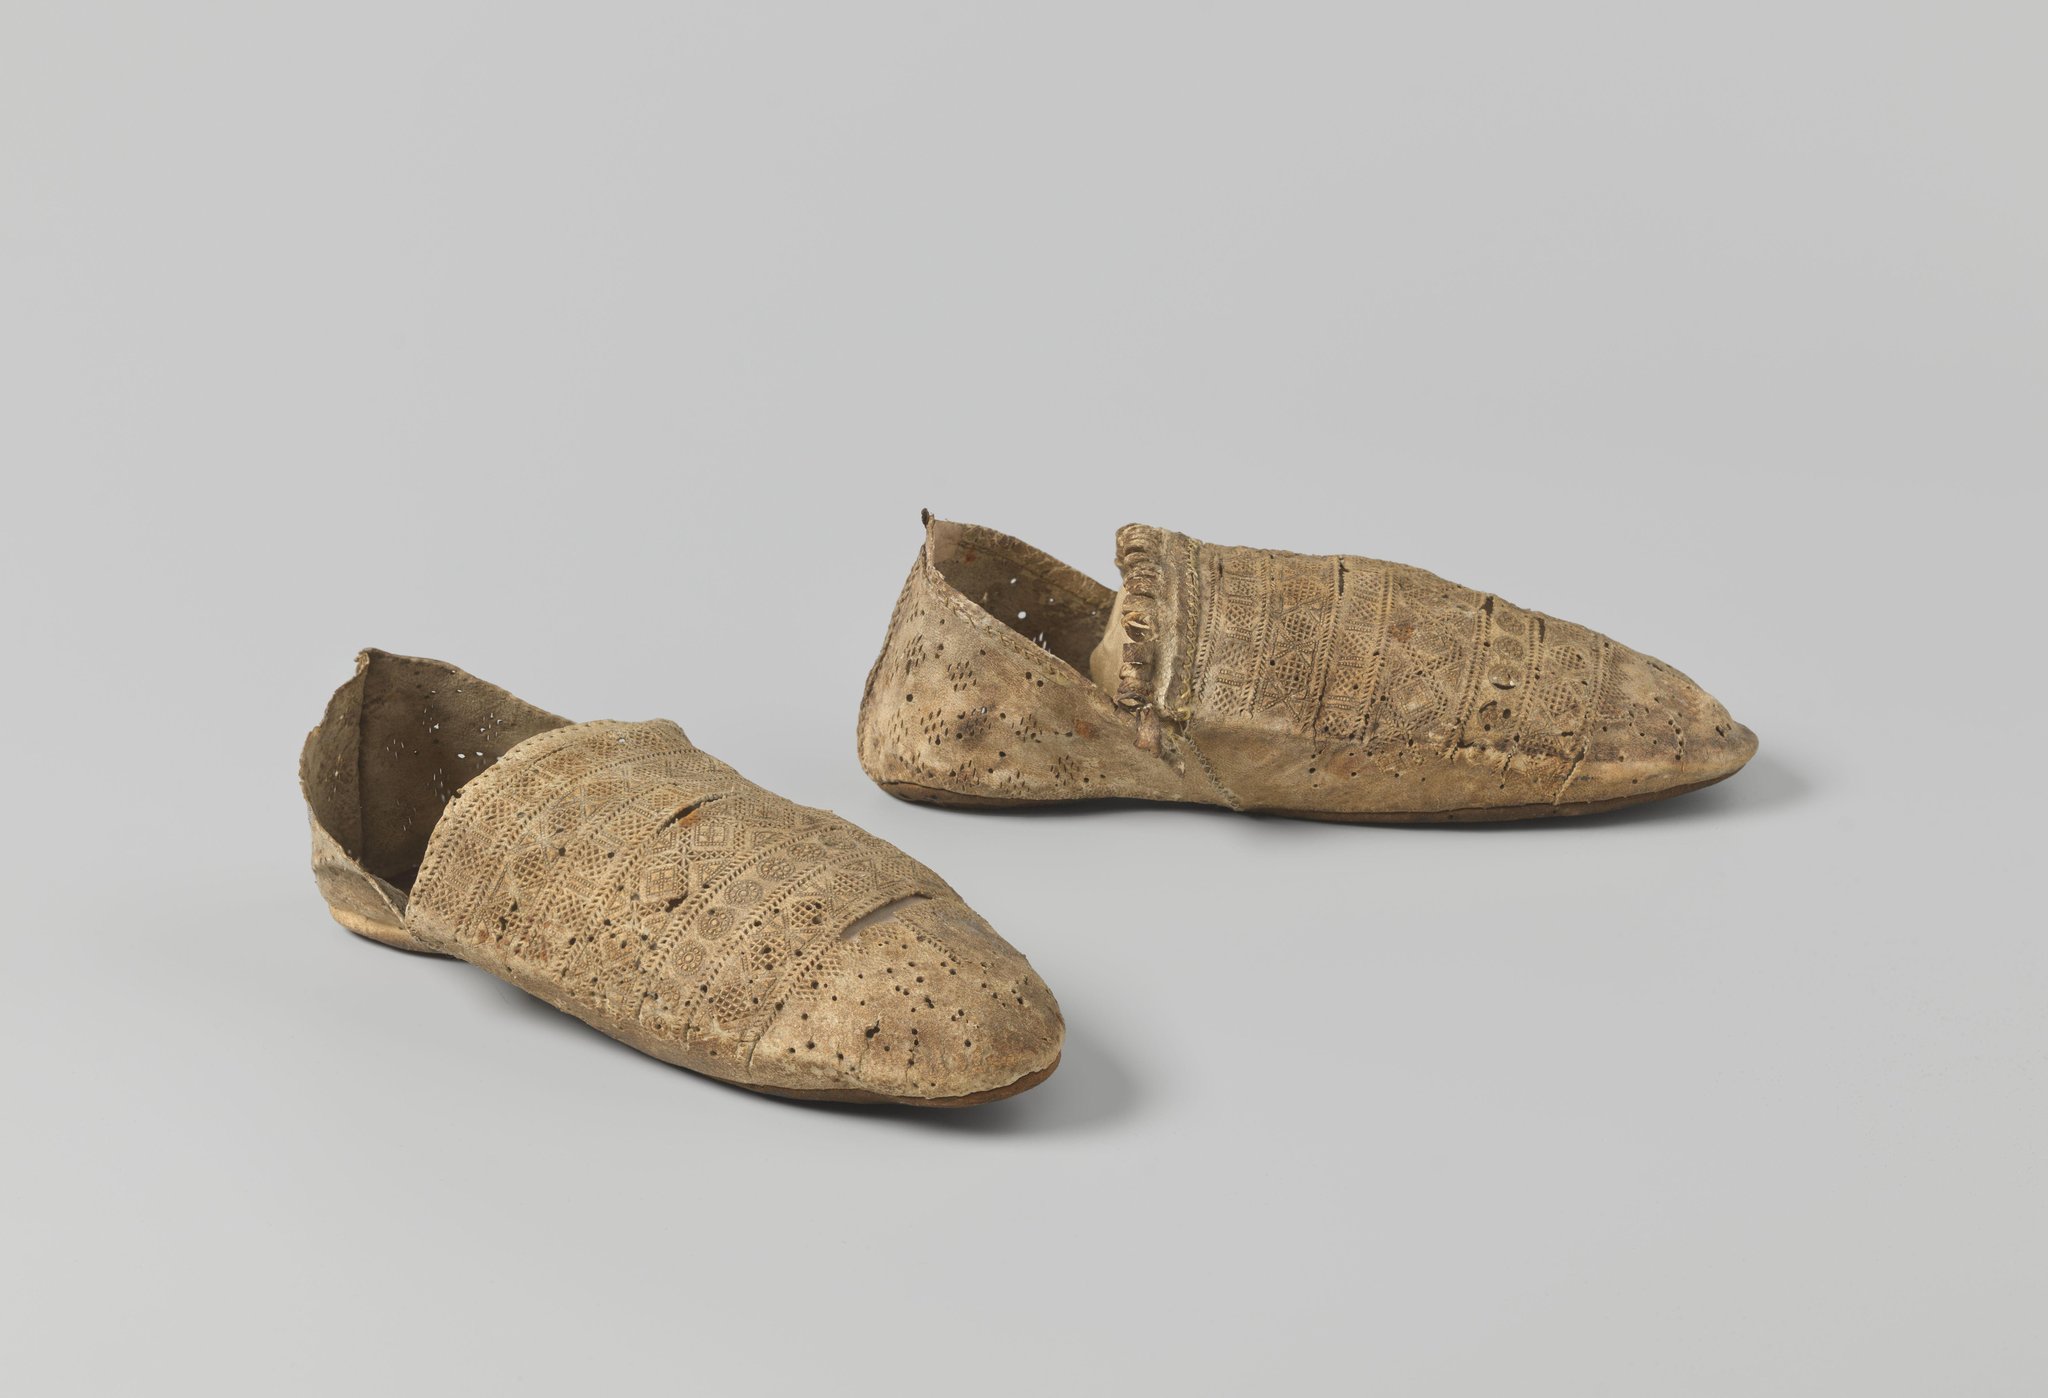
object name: clothing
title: Platte schoen van geiten(?)leer met versierd voorblad waarin rozetten, ruiten en wafelpatronen zijn gestanst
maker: Anonymous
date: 1550-1574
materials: leather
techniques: manufacturing, snipping, tanning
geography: northern netherlands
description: Paar instapschoenen Geiten(?)leer Omstreeks 1540 worden de eerste instapschoenen gemaakt. Het hoge voorblad gaf moeilijkheden met instappen en tijdens het lopen. Om inscheuring te voorkomen en het comfort van de drager te vergroten, werd het voorblad vaak enkele keren op de wreef ingeknipt of -gesneden. Pair of shoes Goatskin(?) This type of shoes was first made around 1540. The high instep made it difficult to get into the shoe or walk comfortably. To prevent the instep from tearing and giving the wearer more comfort, the upper would often be cut several times on the instep. Nederland/ Netherlands, ca. 1550-1575 Inv. BK-NM-7419